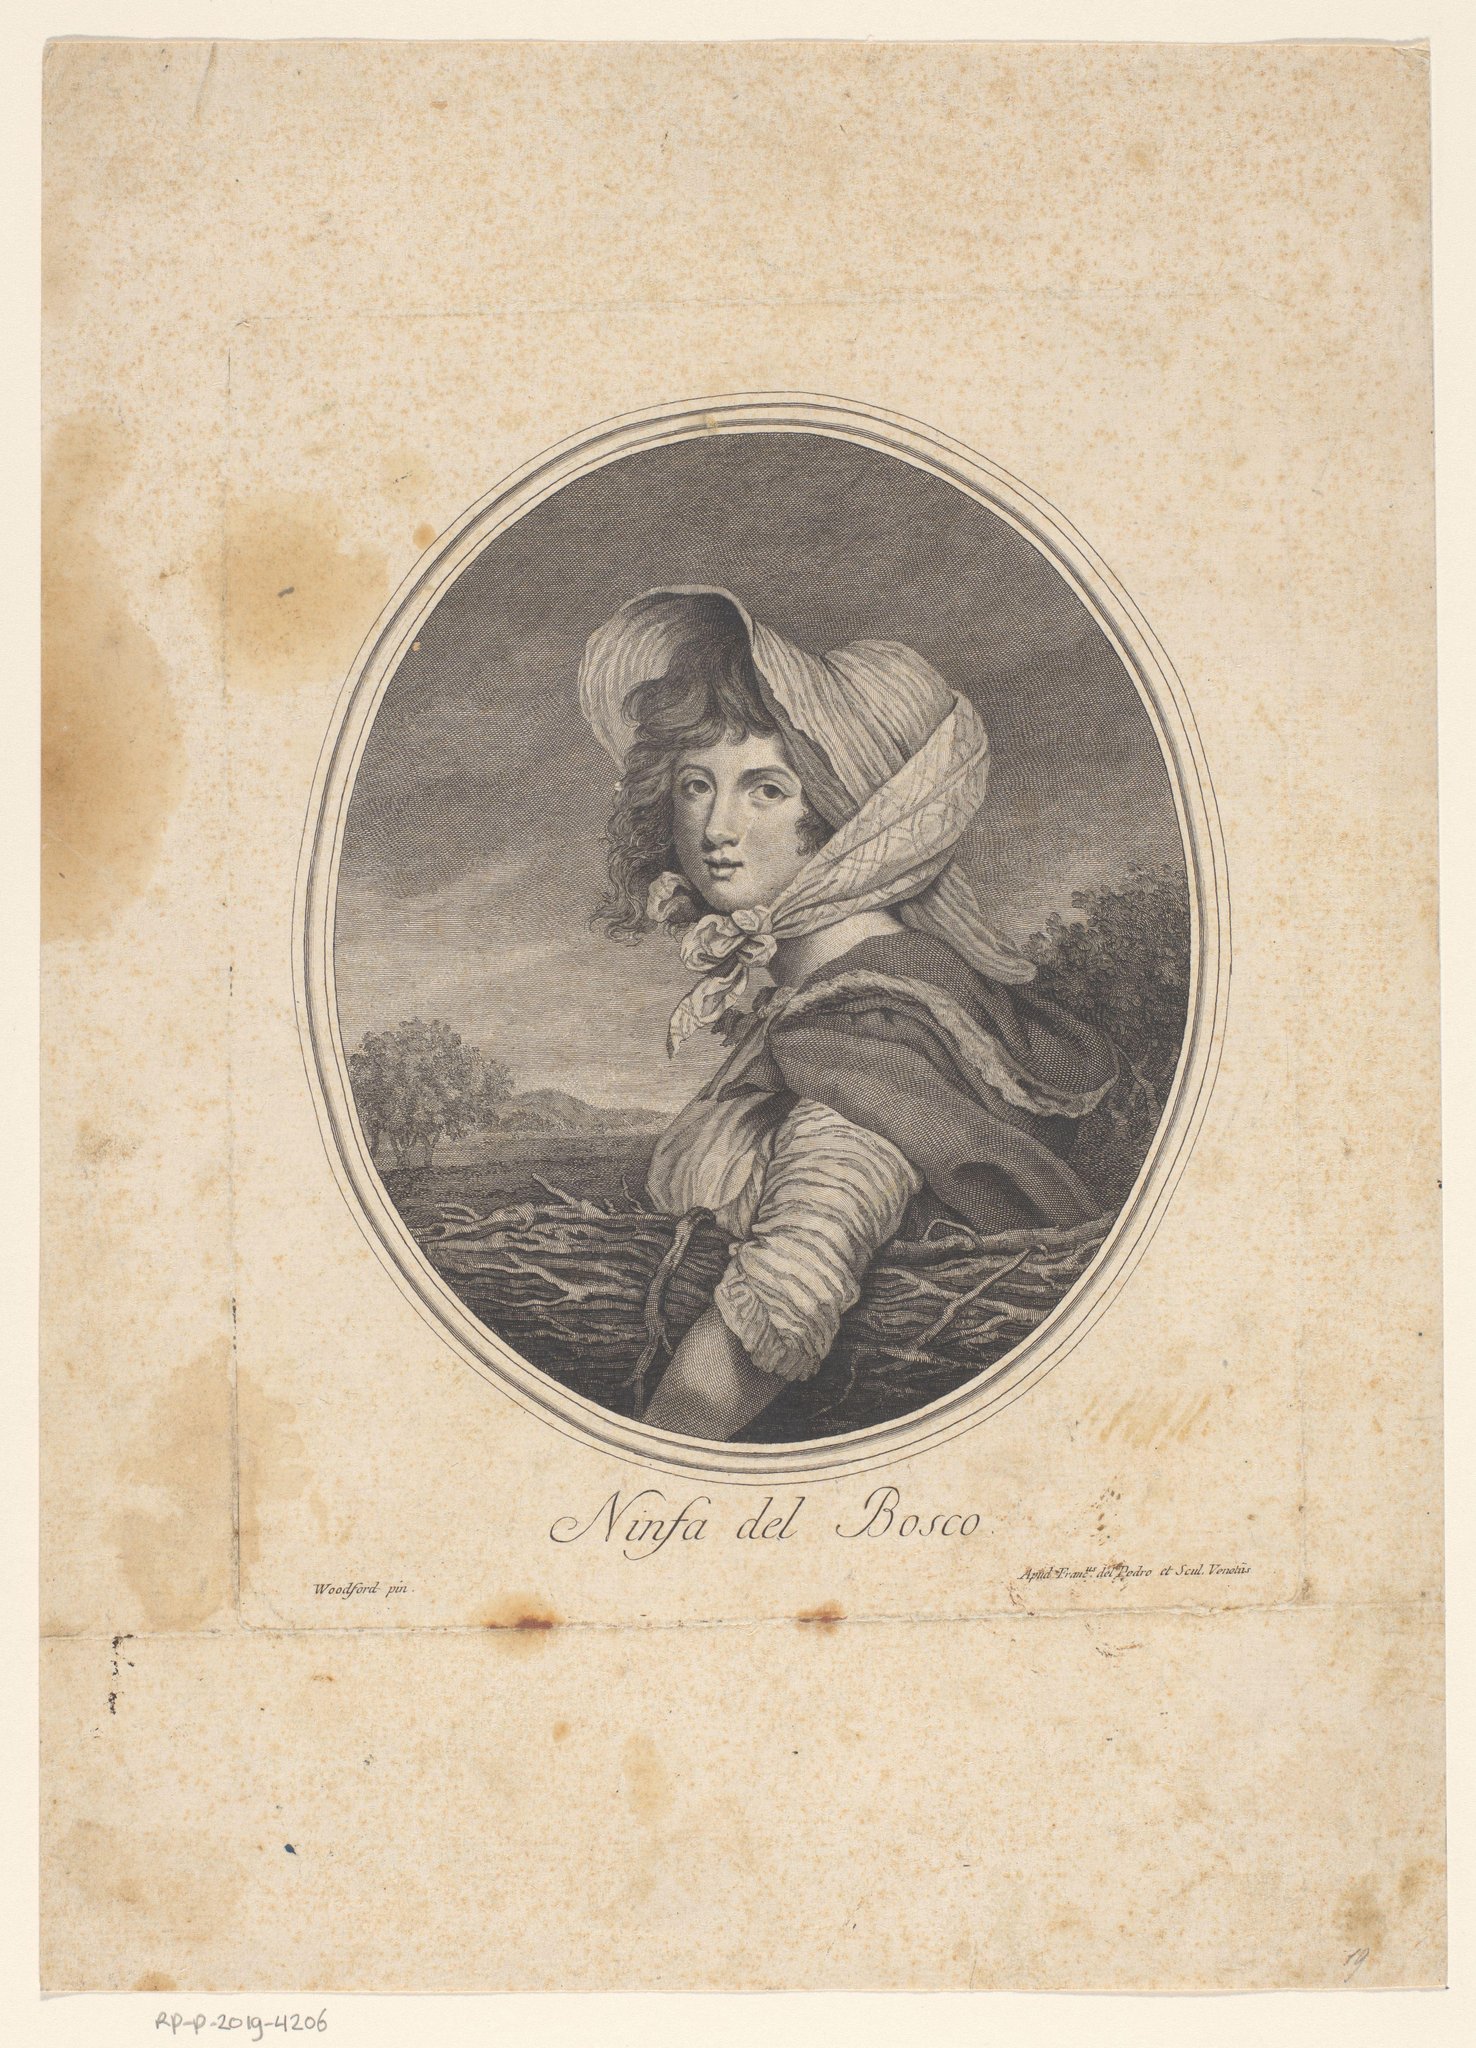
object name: print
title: Ninfa del Bosco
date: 1773-1806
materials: paper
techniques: etching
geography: venice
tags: herding, herdsman, herdswoman, shepherd, shepherdess, cowherd, etc.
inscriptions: collector's mark: Lugt 2228, collector's mark: Lugt 2760